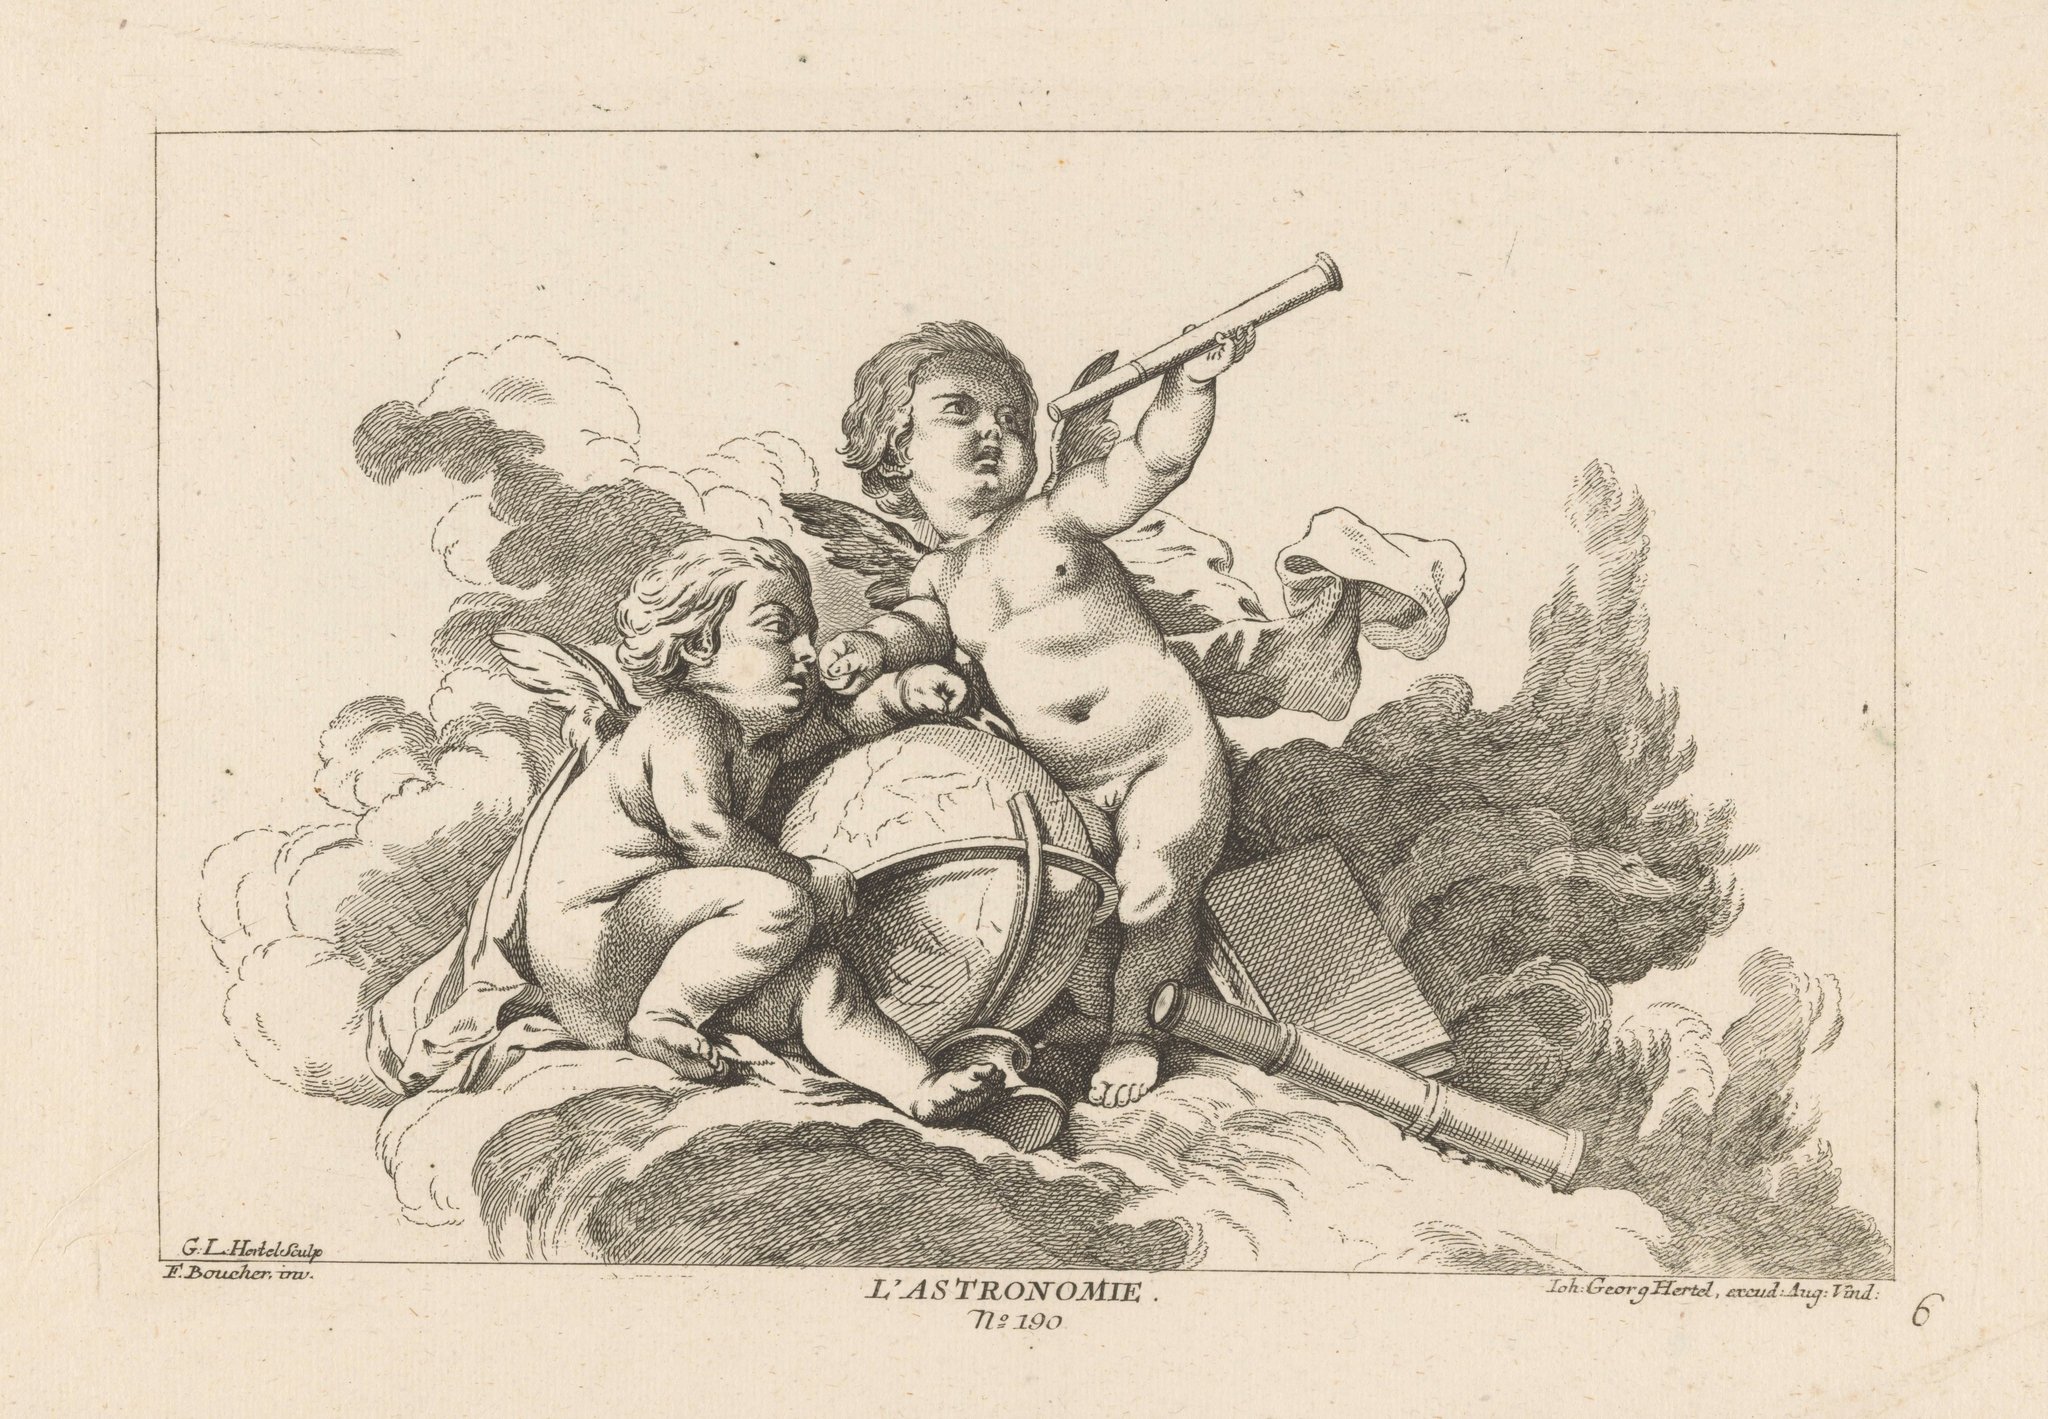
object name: print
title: Astronomie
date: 1750-1778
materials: paper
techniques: engraving, etching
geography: augsburg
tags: 'astronomia', 'cosmografia'; 'cosmografia' (ripa), cupids: 'amores', 'amoretti', 'putti'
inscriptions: collector's mark: Lugt 2228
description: Allegorie van de astronomie. Twee putti met telescopen en een globe. Uitgeversnummer 190.